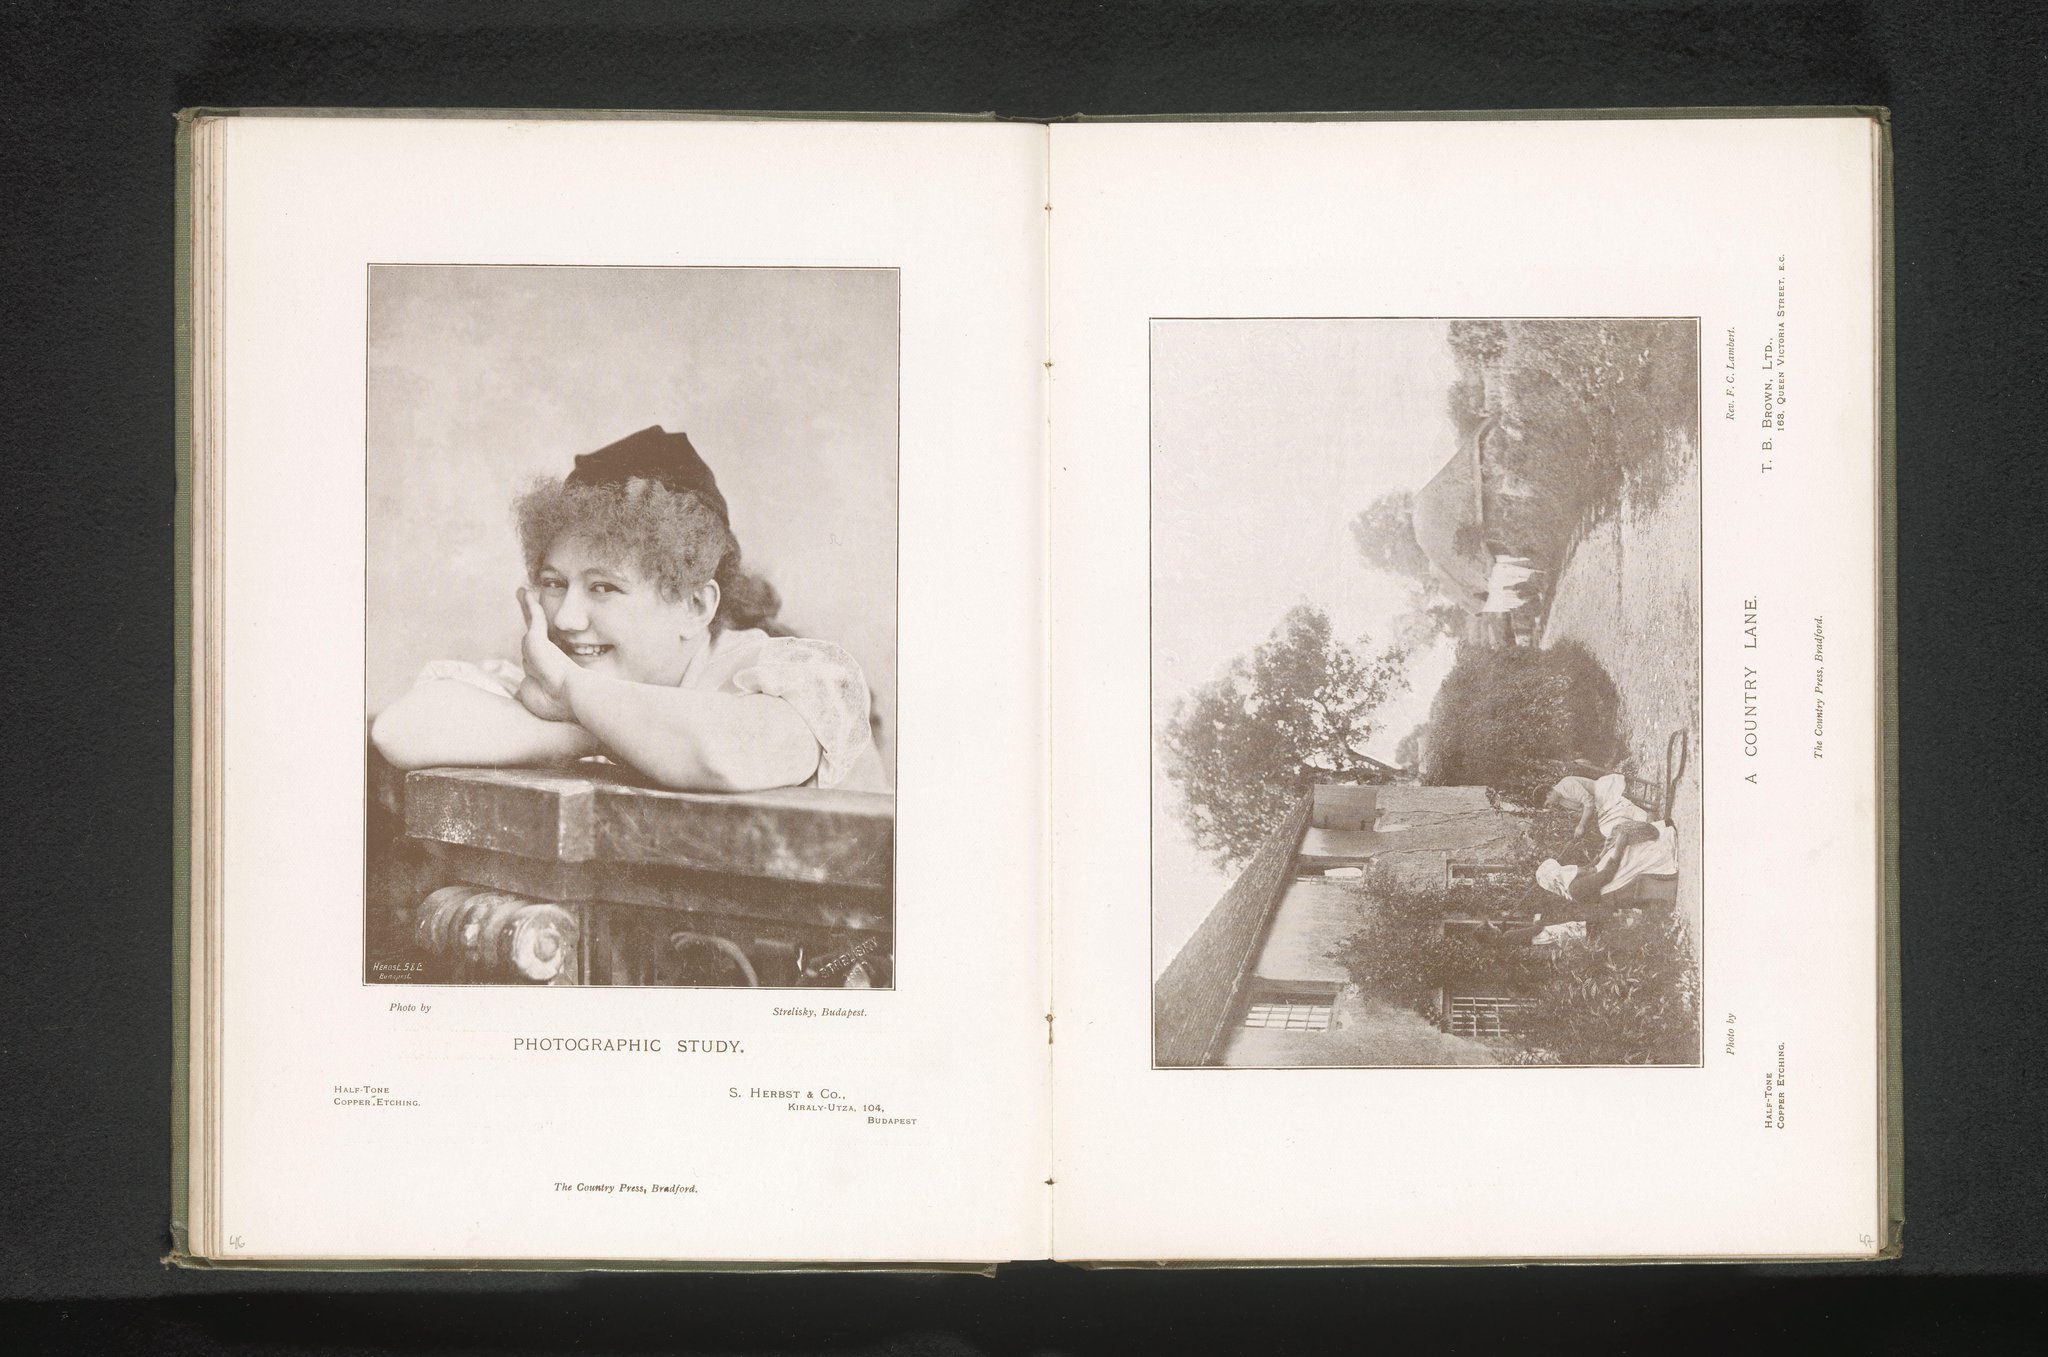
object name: photomechanical print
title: Dorpsgezicht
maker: f.c. lambert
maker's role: fotograaf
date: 1893-1898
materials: paper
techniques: autotype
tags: village street (+ city(-scape) with figures, staffage)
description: Prent op derde ongenummerde pagina na pagina 56.